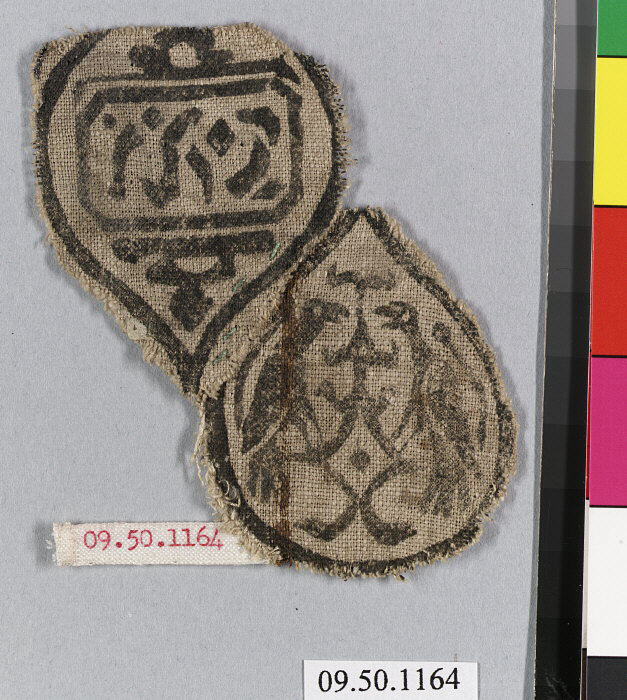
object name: fragment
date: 1101-1300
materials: linen